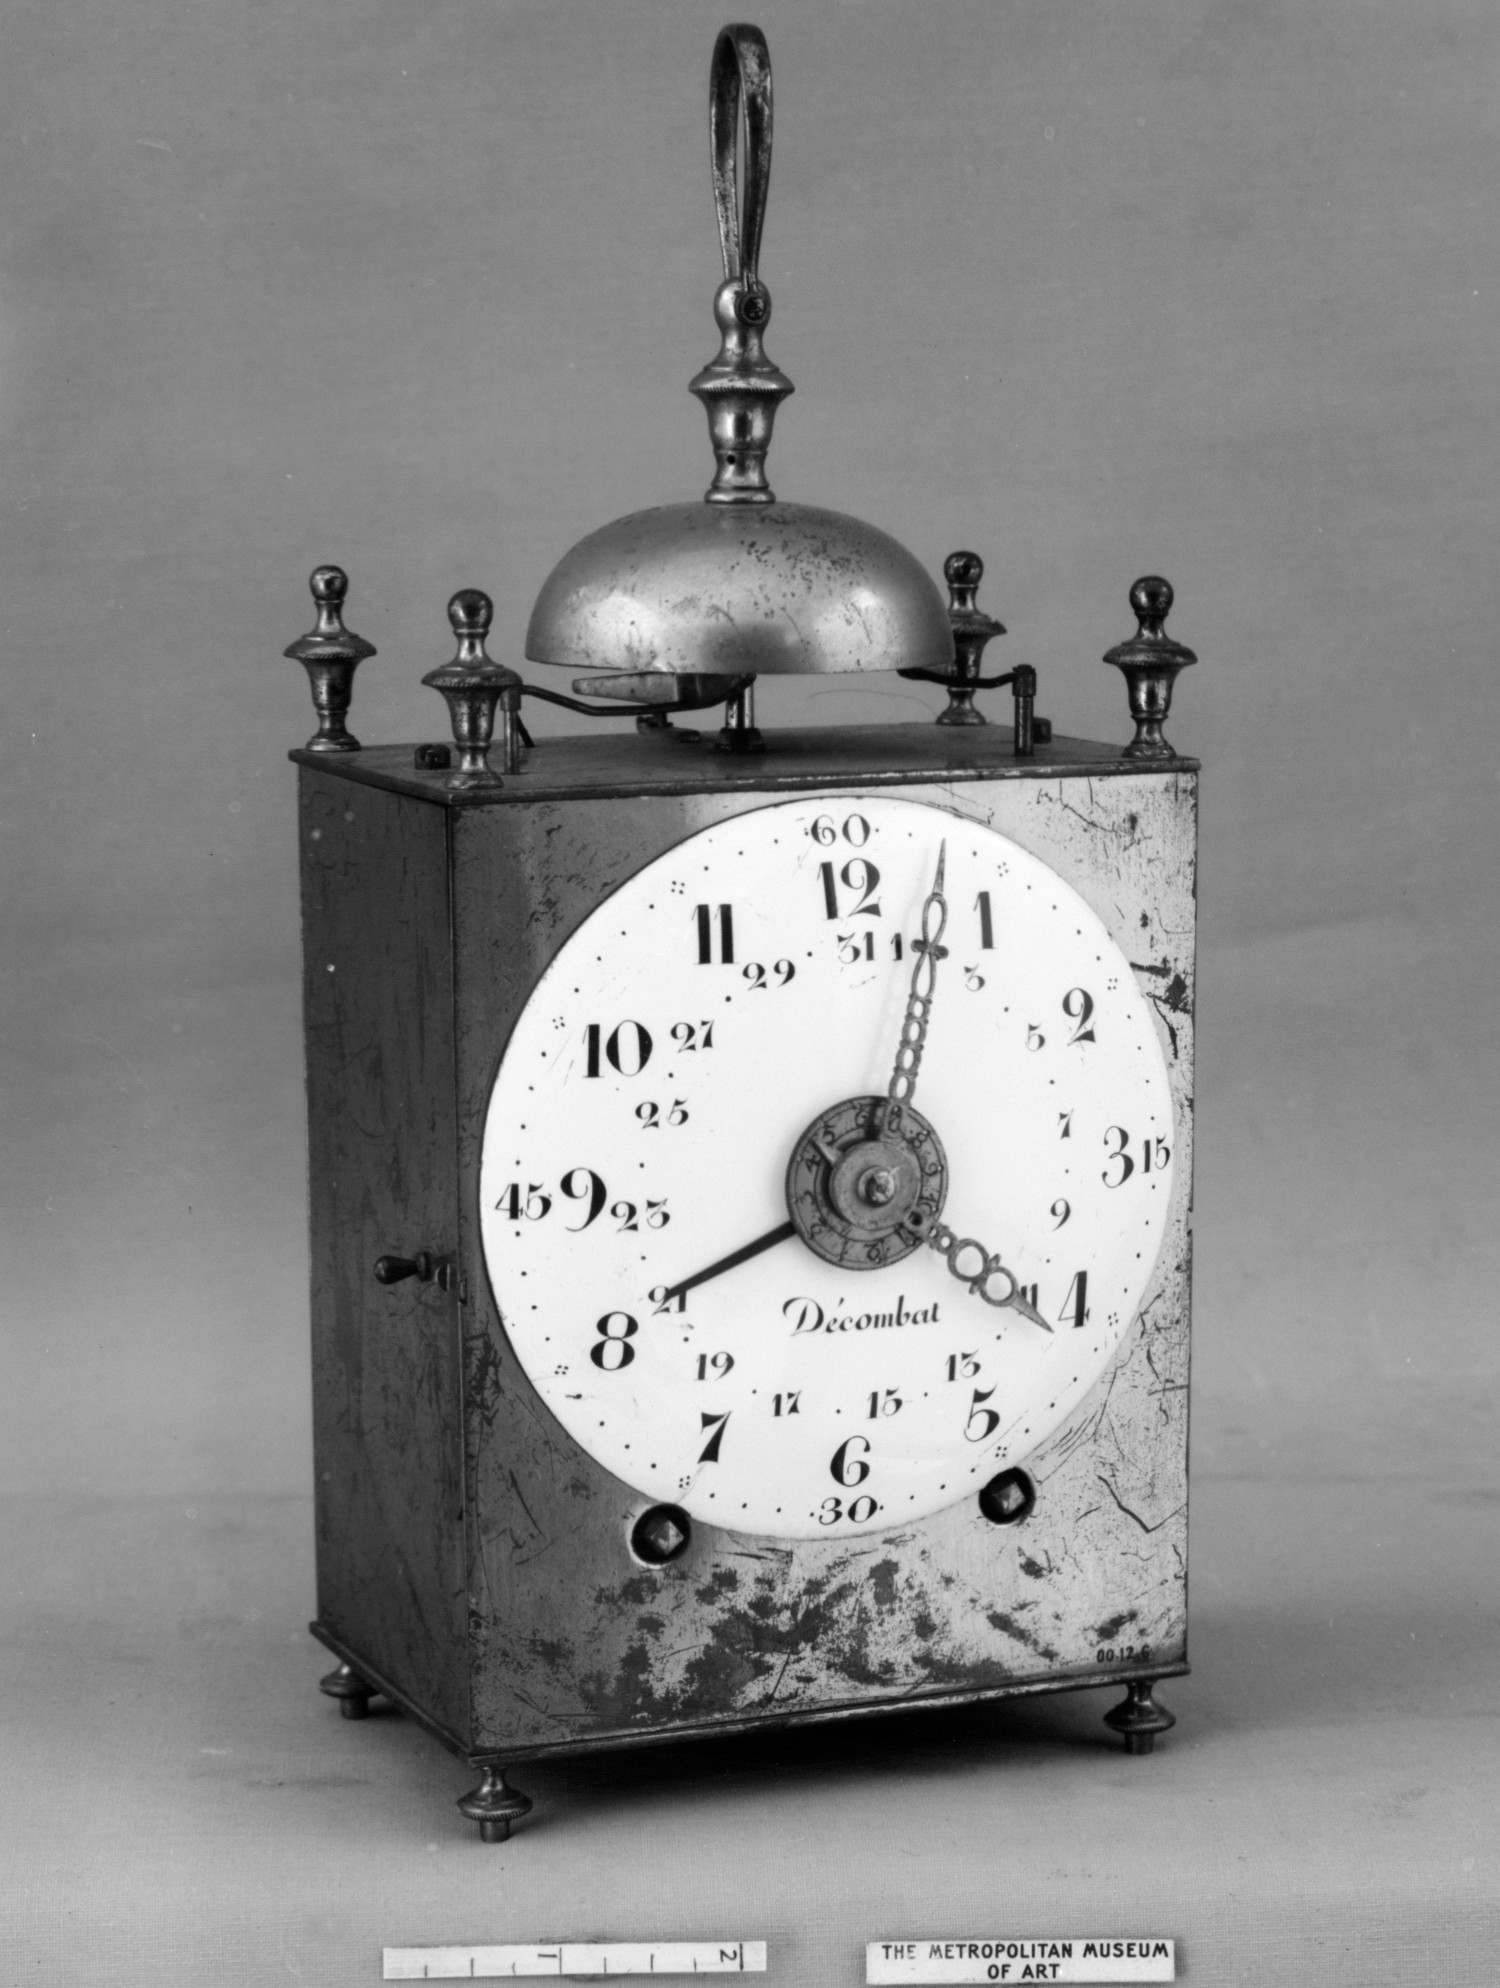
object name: portable clock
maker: décombat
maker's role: maker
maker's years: 1800-1900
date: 1801-1900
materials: brass, enamel